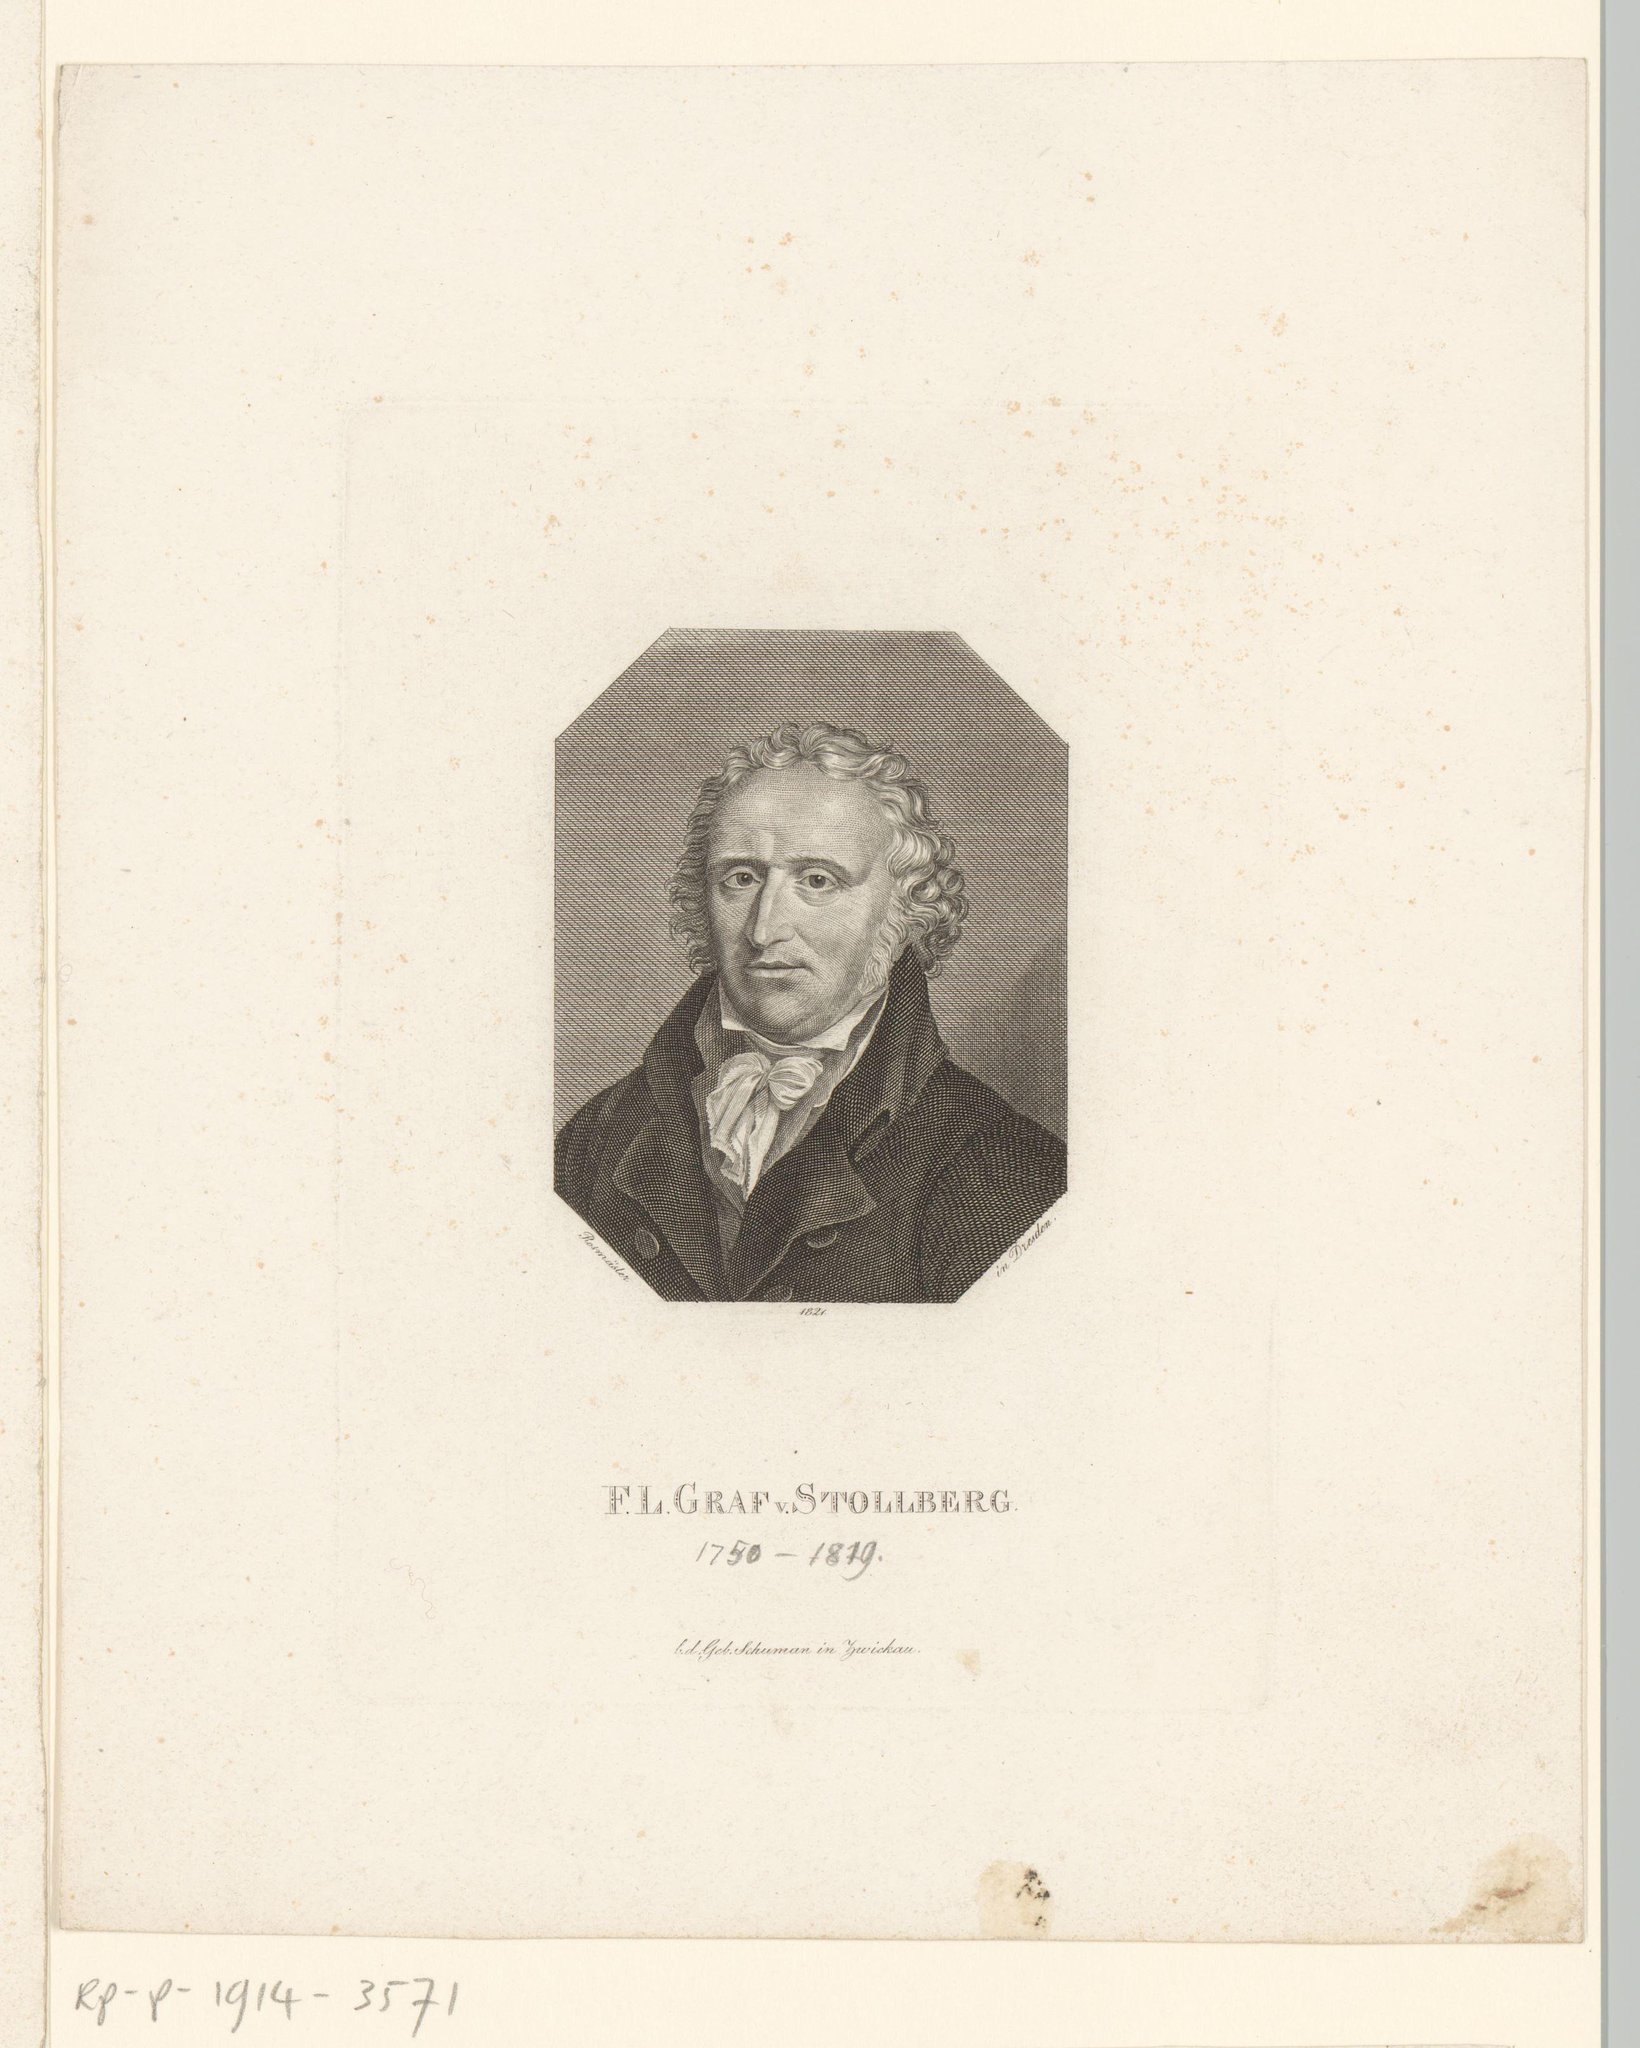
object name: print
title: Portret van Friedrich Leopold, graaf van Stolberg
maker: friedrich rossmässler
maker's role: print maker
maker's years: 1775-1858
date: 1785-1858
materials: paper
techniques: engraving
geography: zwickau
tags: historical persons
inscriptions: collector's mark: Lugt 2228, date